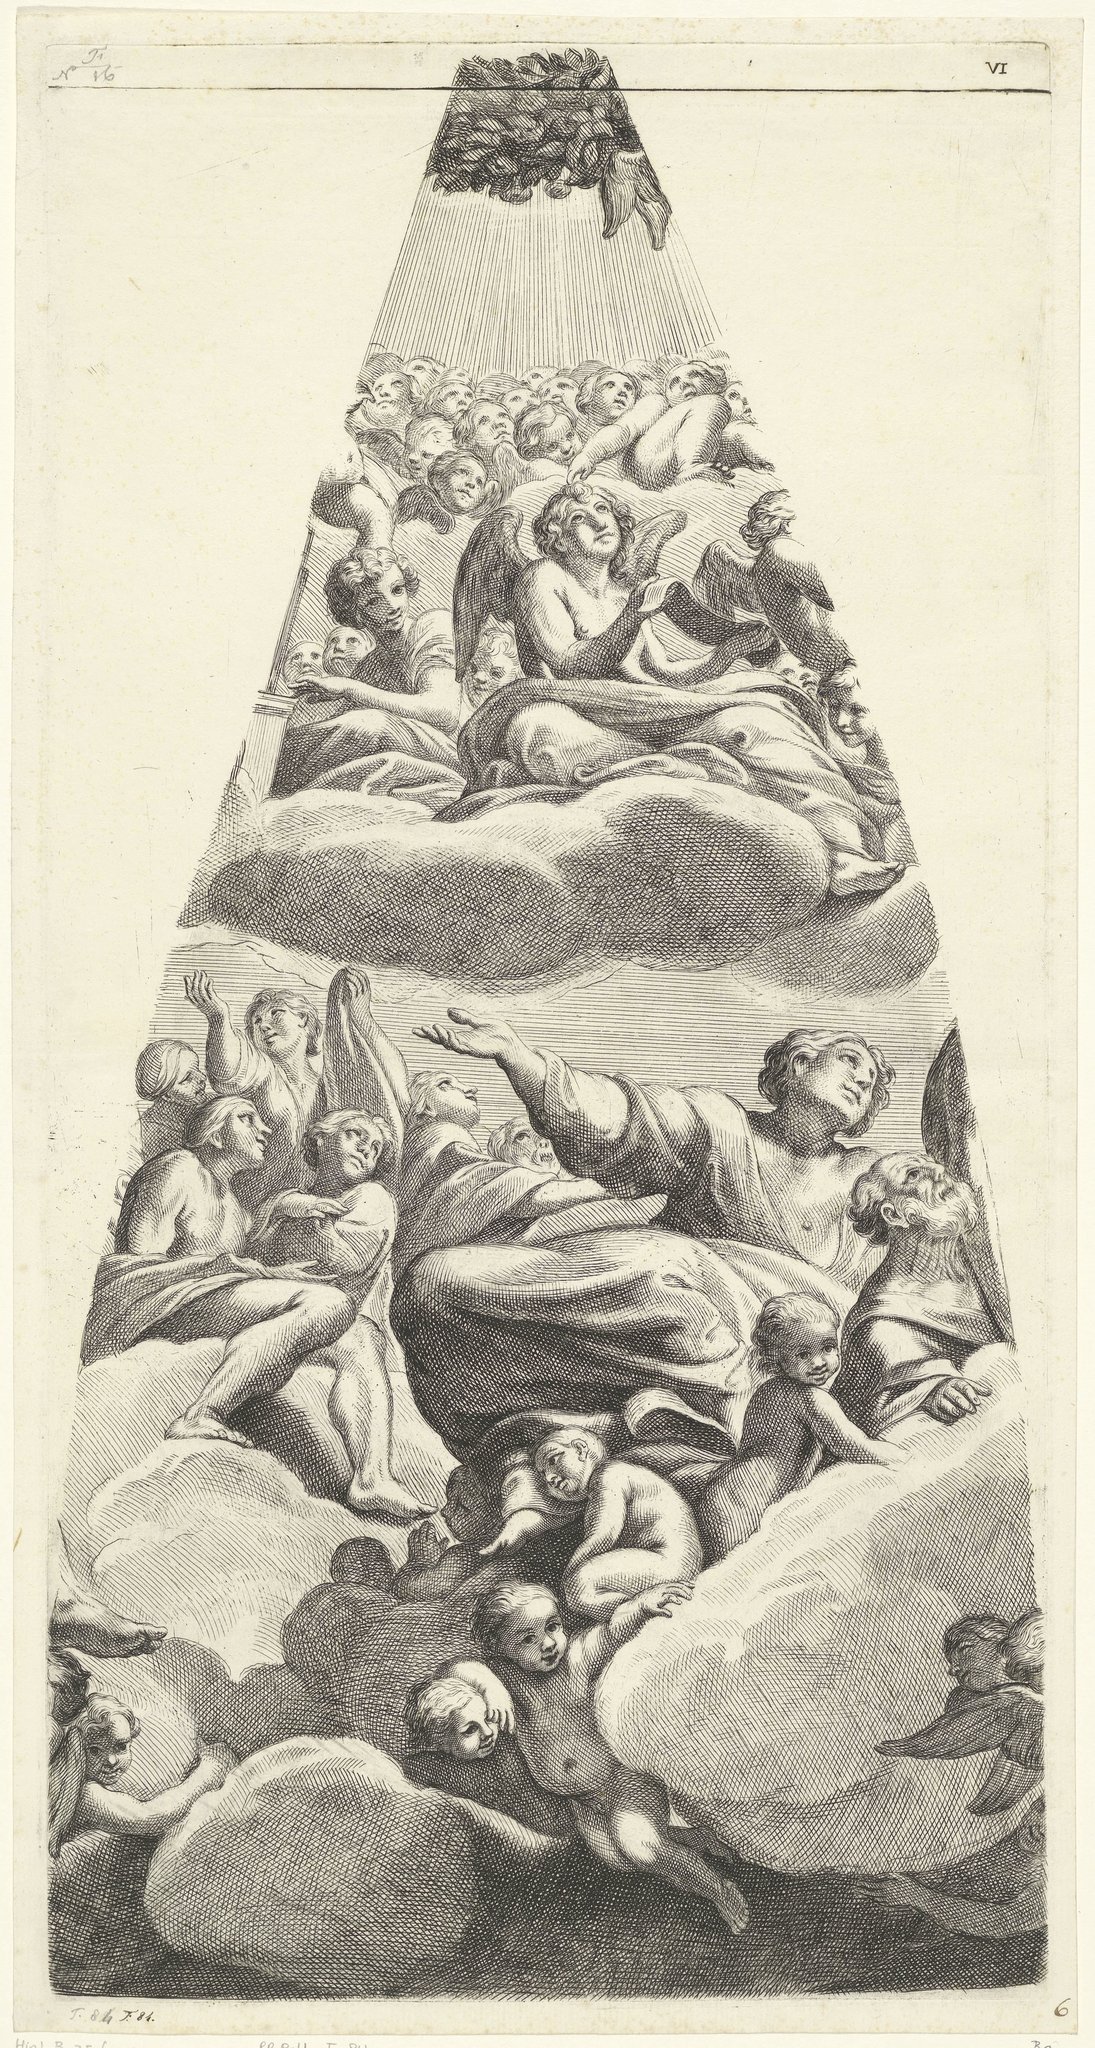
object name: print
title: Hemelvaart van Maria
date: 1680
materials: paper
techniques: engraving, etching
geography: italy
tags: saints, angels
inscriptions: number: ‘6’, collector's mark: ‘Hinloopen’, collector's mark: Lugt 11, collector's mark: Lugt 10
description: Prent uit een reeks van 8 prenten naar de fresco's door Giovanni Lanfranco in de koepel van de San Andrea della Valle te Rome.